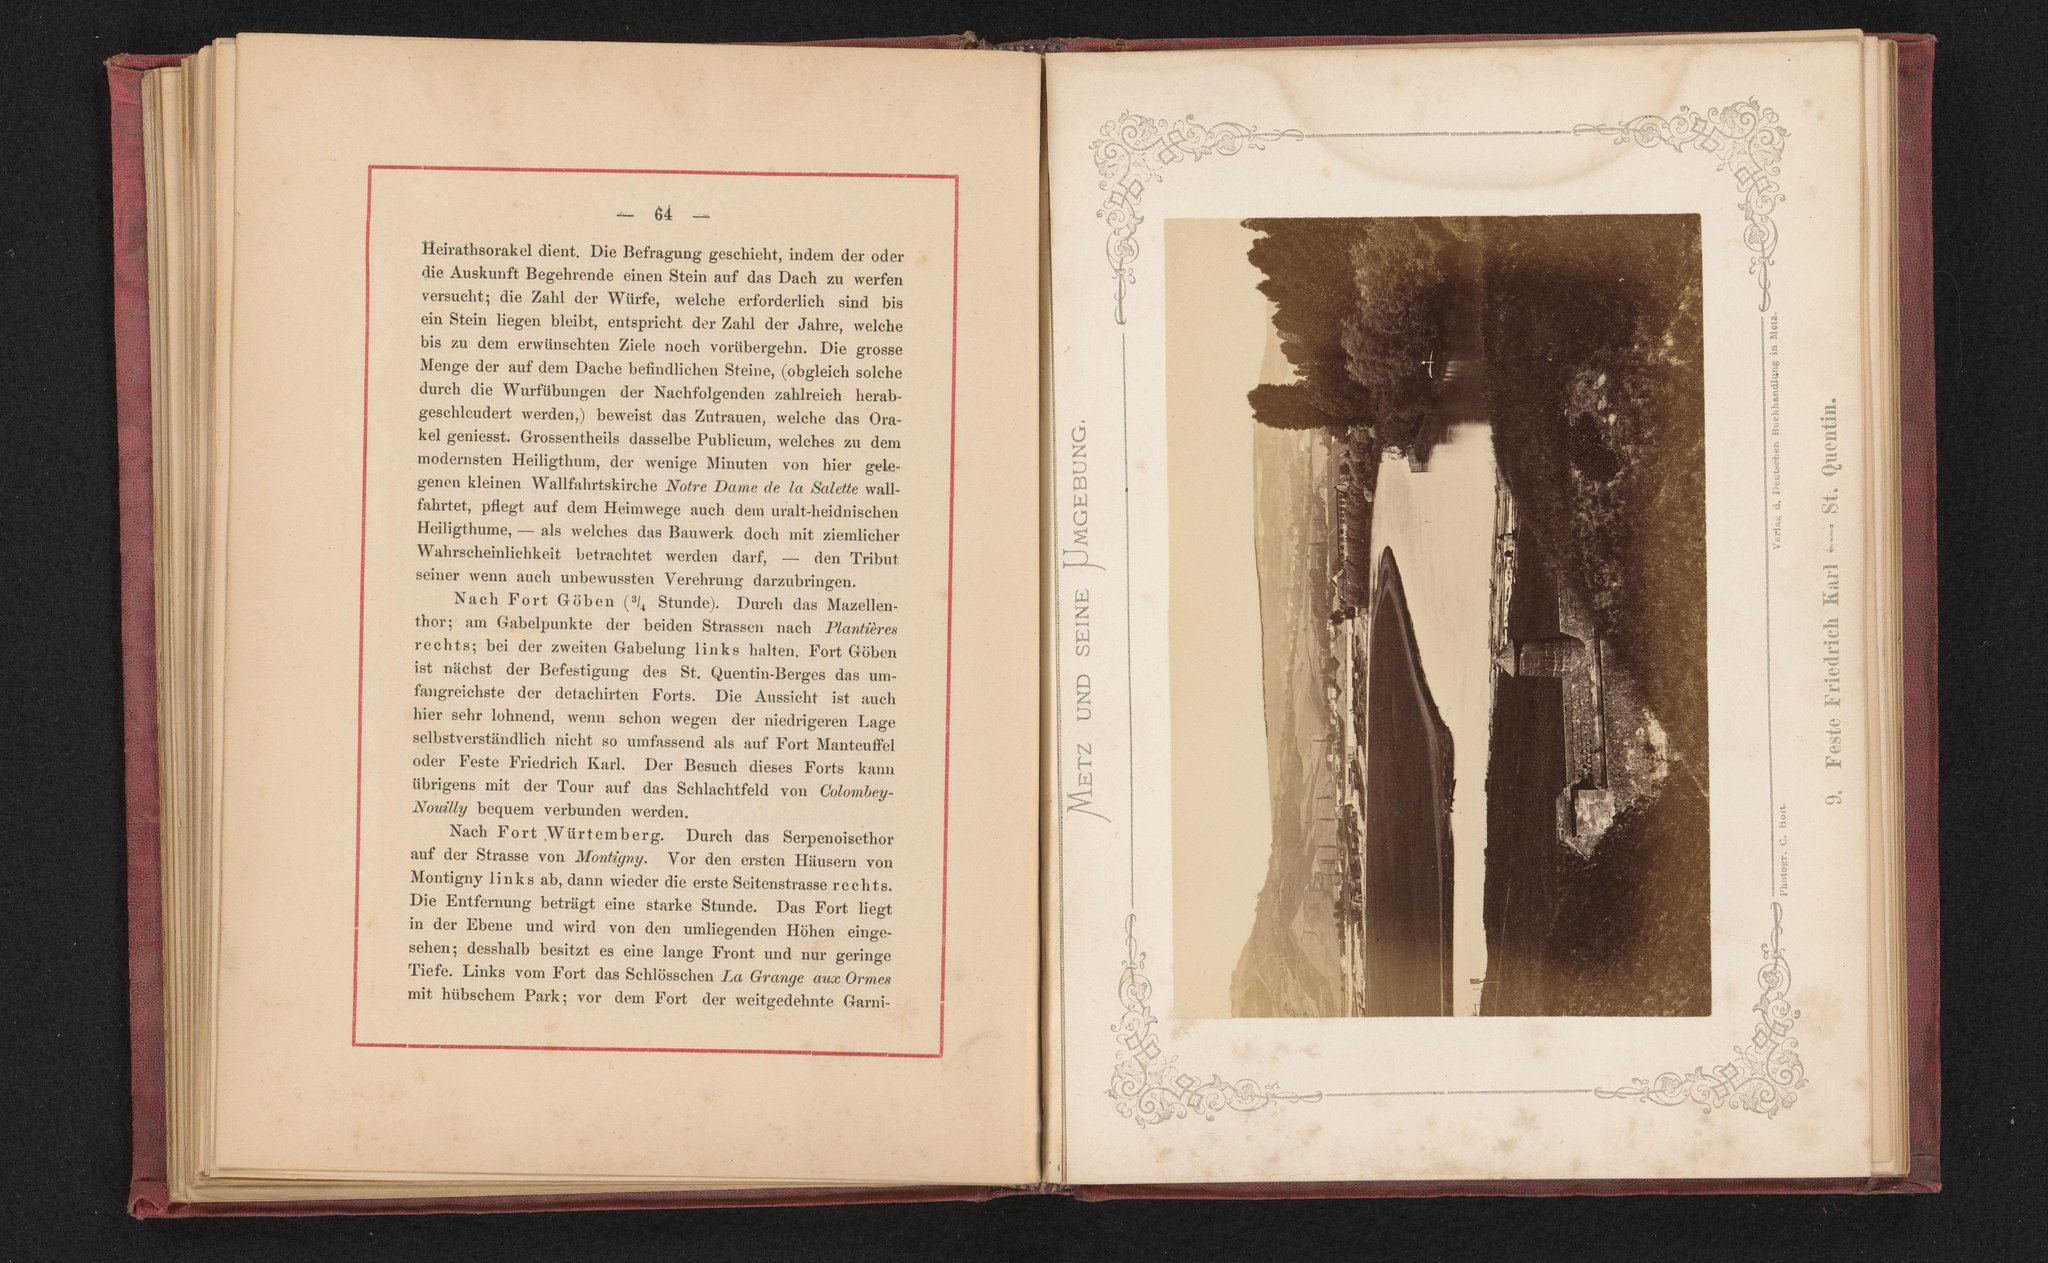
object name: page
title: Metz und seine Umgebung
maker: c. holt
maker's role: fotograaf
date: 1865-1875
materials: photographic support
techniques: albumen print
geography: metz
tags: defence of fortification or city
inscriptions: number: ‘9.’